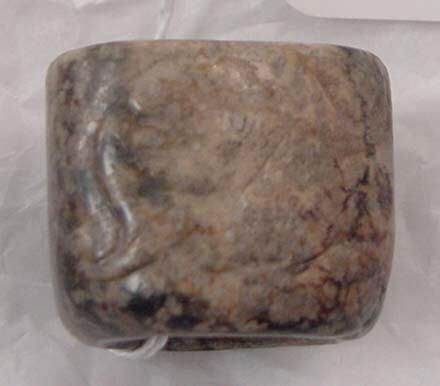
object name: ring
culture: chinese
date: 1801-1900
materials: marble